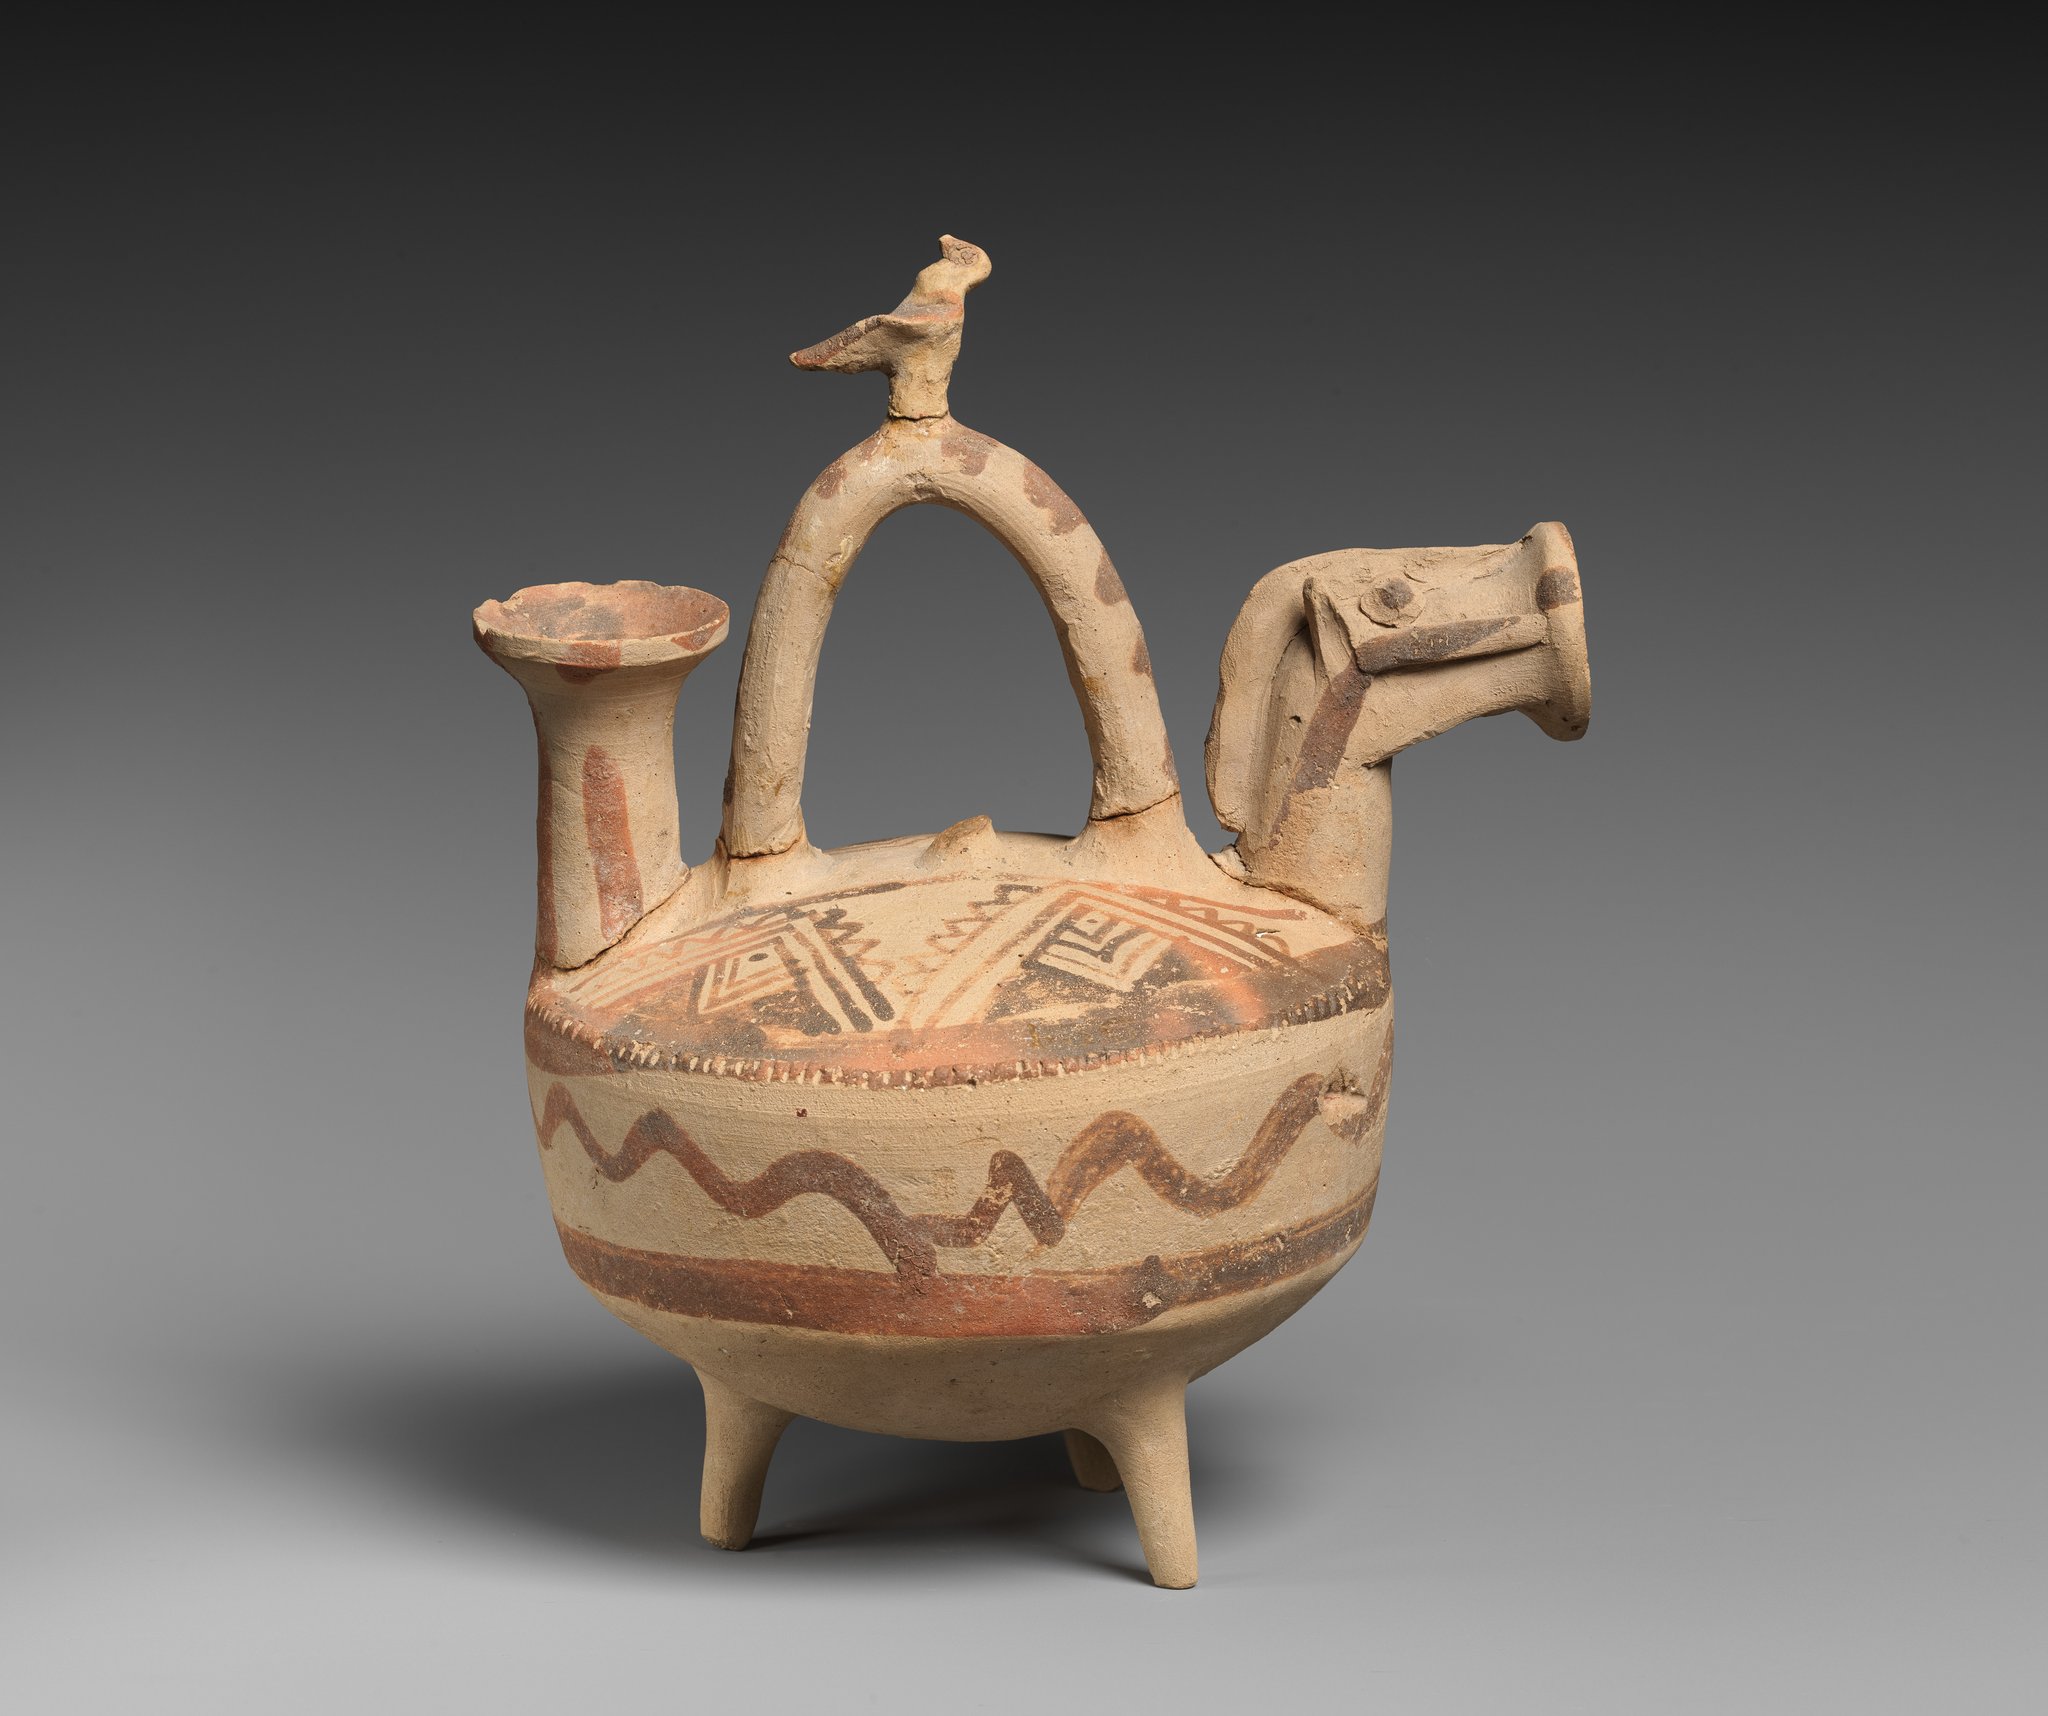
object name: askos with horse protome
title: Terracotta askos (vessel) with horse protome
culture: cypriot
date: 1200-1050 BCE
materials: terracotta